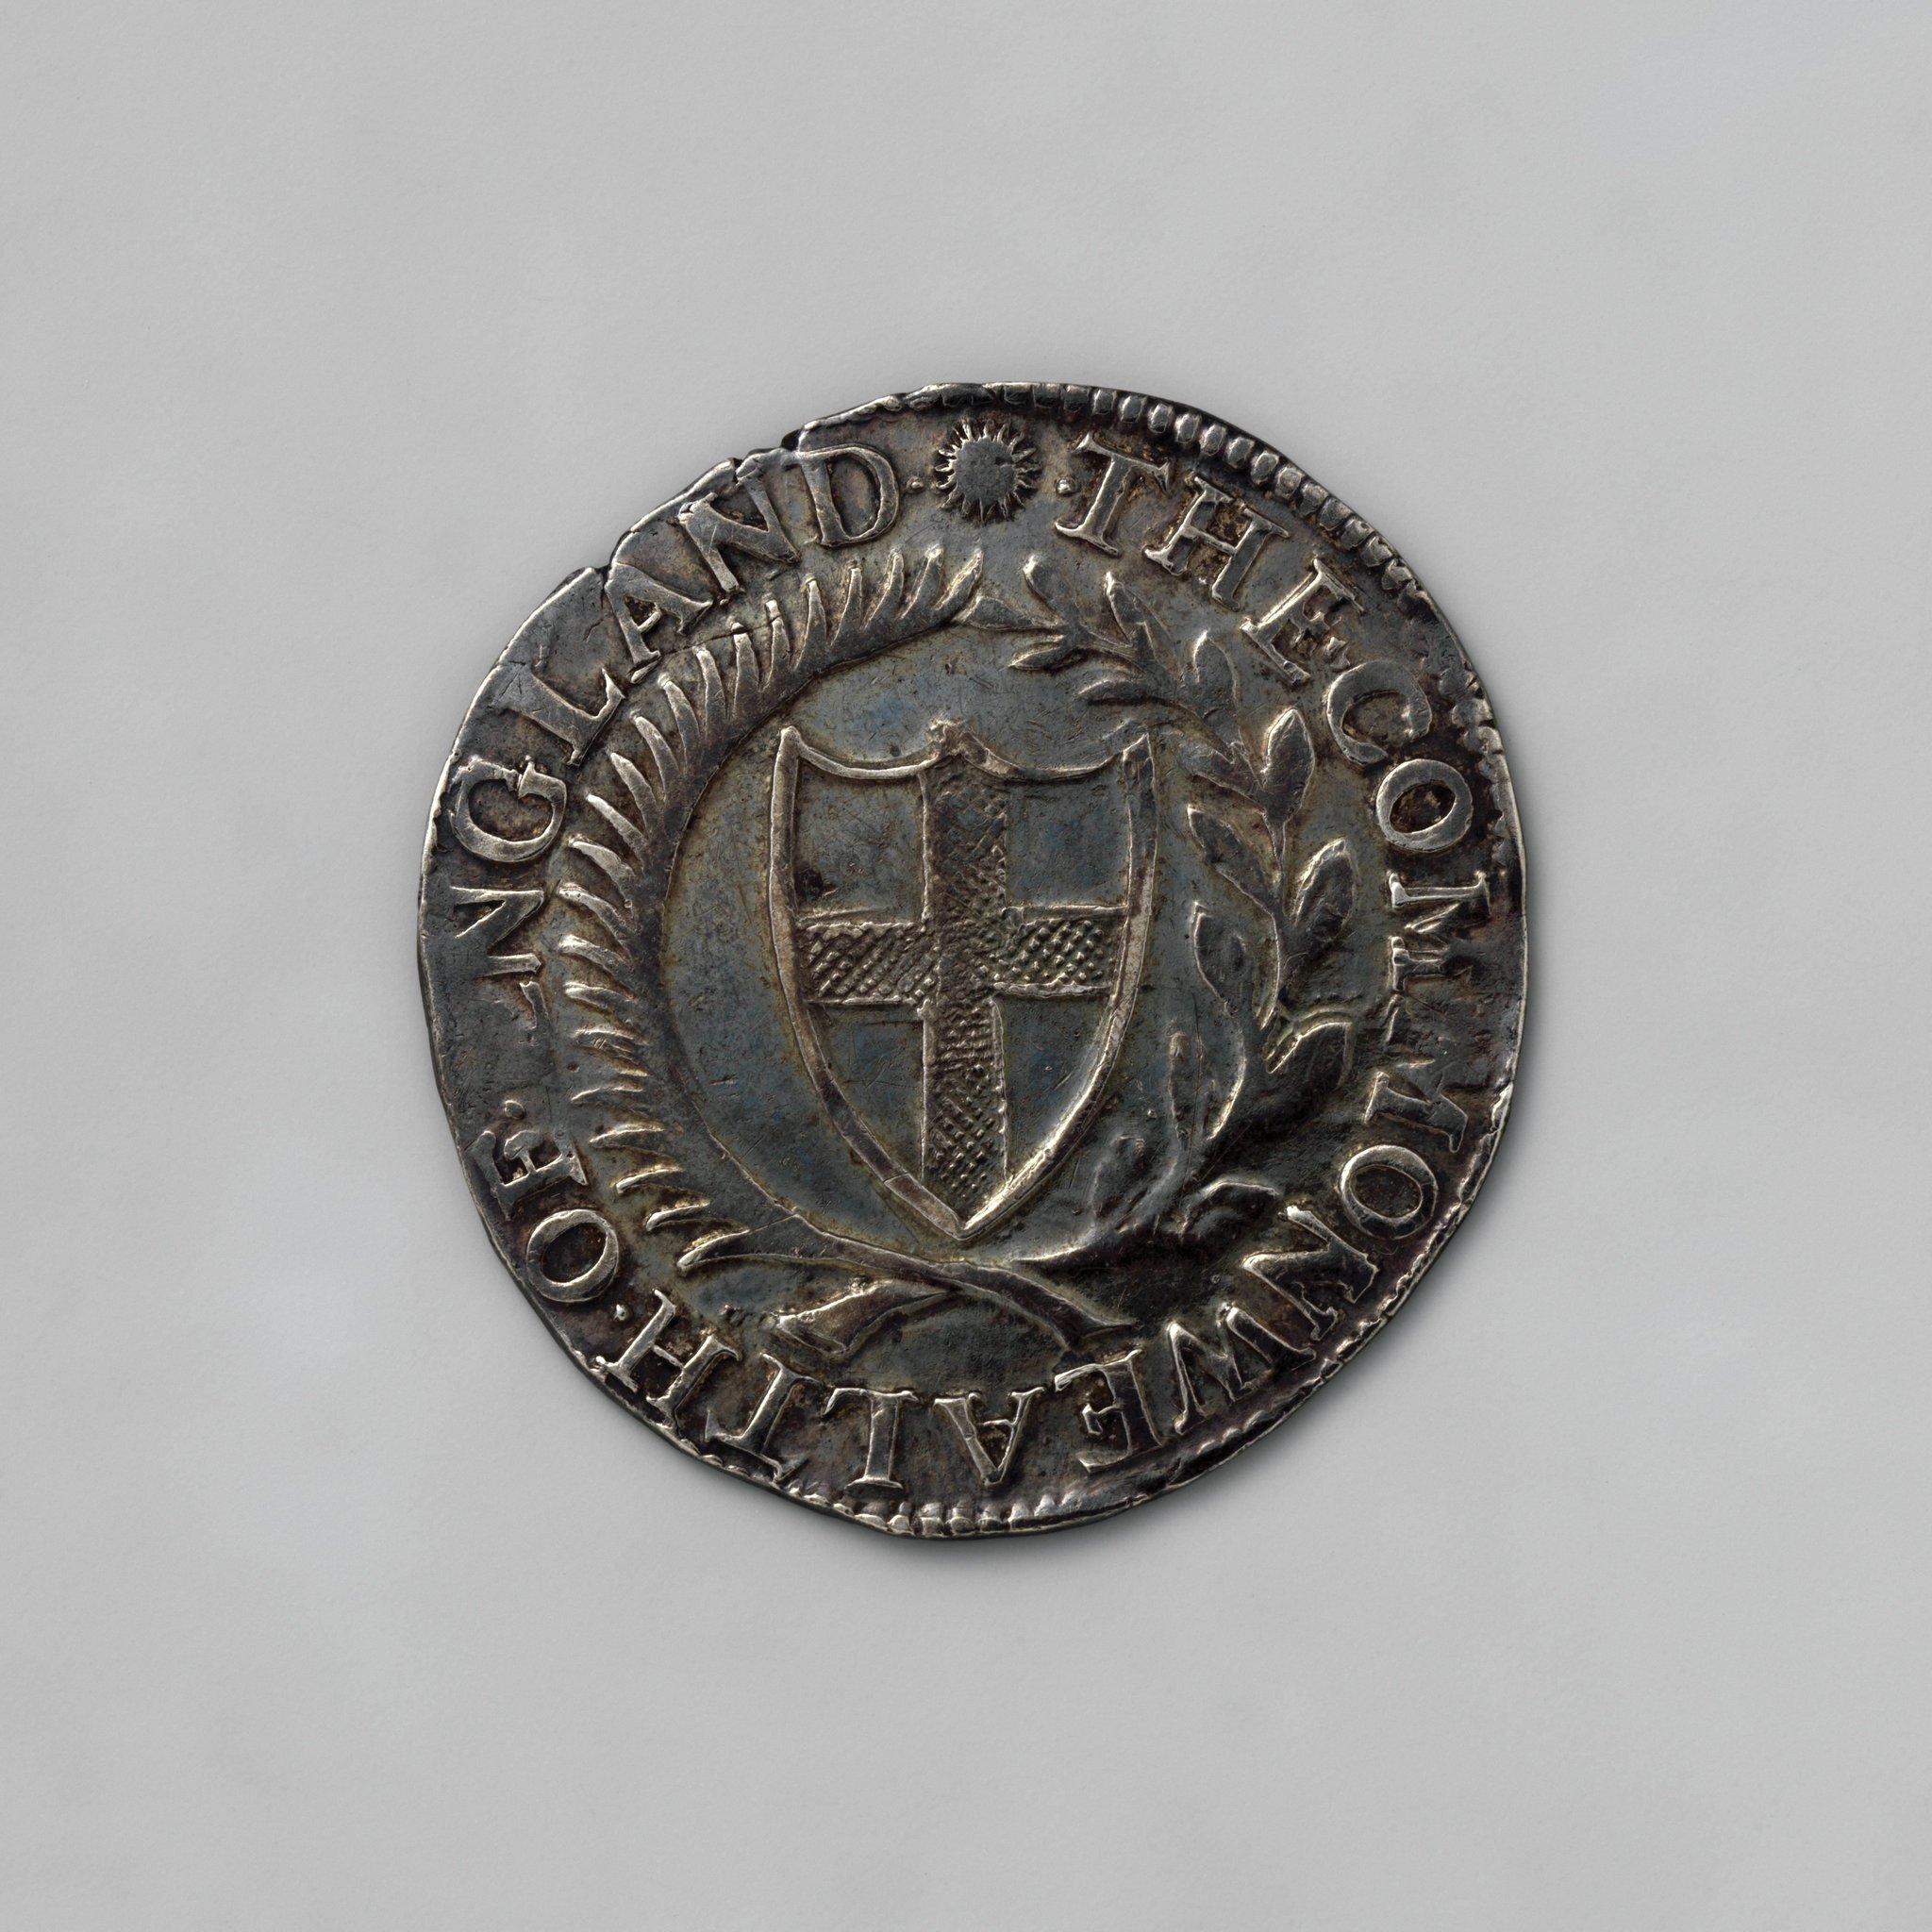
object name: coin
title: Shilling uit Engeland tijdens protectoraat van Cromwell, 1659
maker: Anonymous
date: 1659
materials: silver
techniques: striking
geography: london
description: Zilveren munt. Voorzijde: binnen twee gekruiste takken wapenschild. Keerzijde: twee naast elkaar geplaatste wapenschilden, waarboven waarde-aanduiding: XII [=12 pence]. Jaartal in omschrift bovenaan.